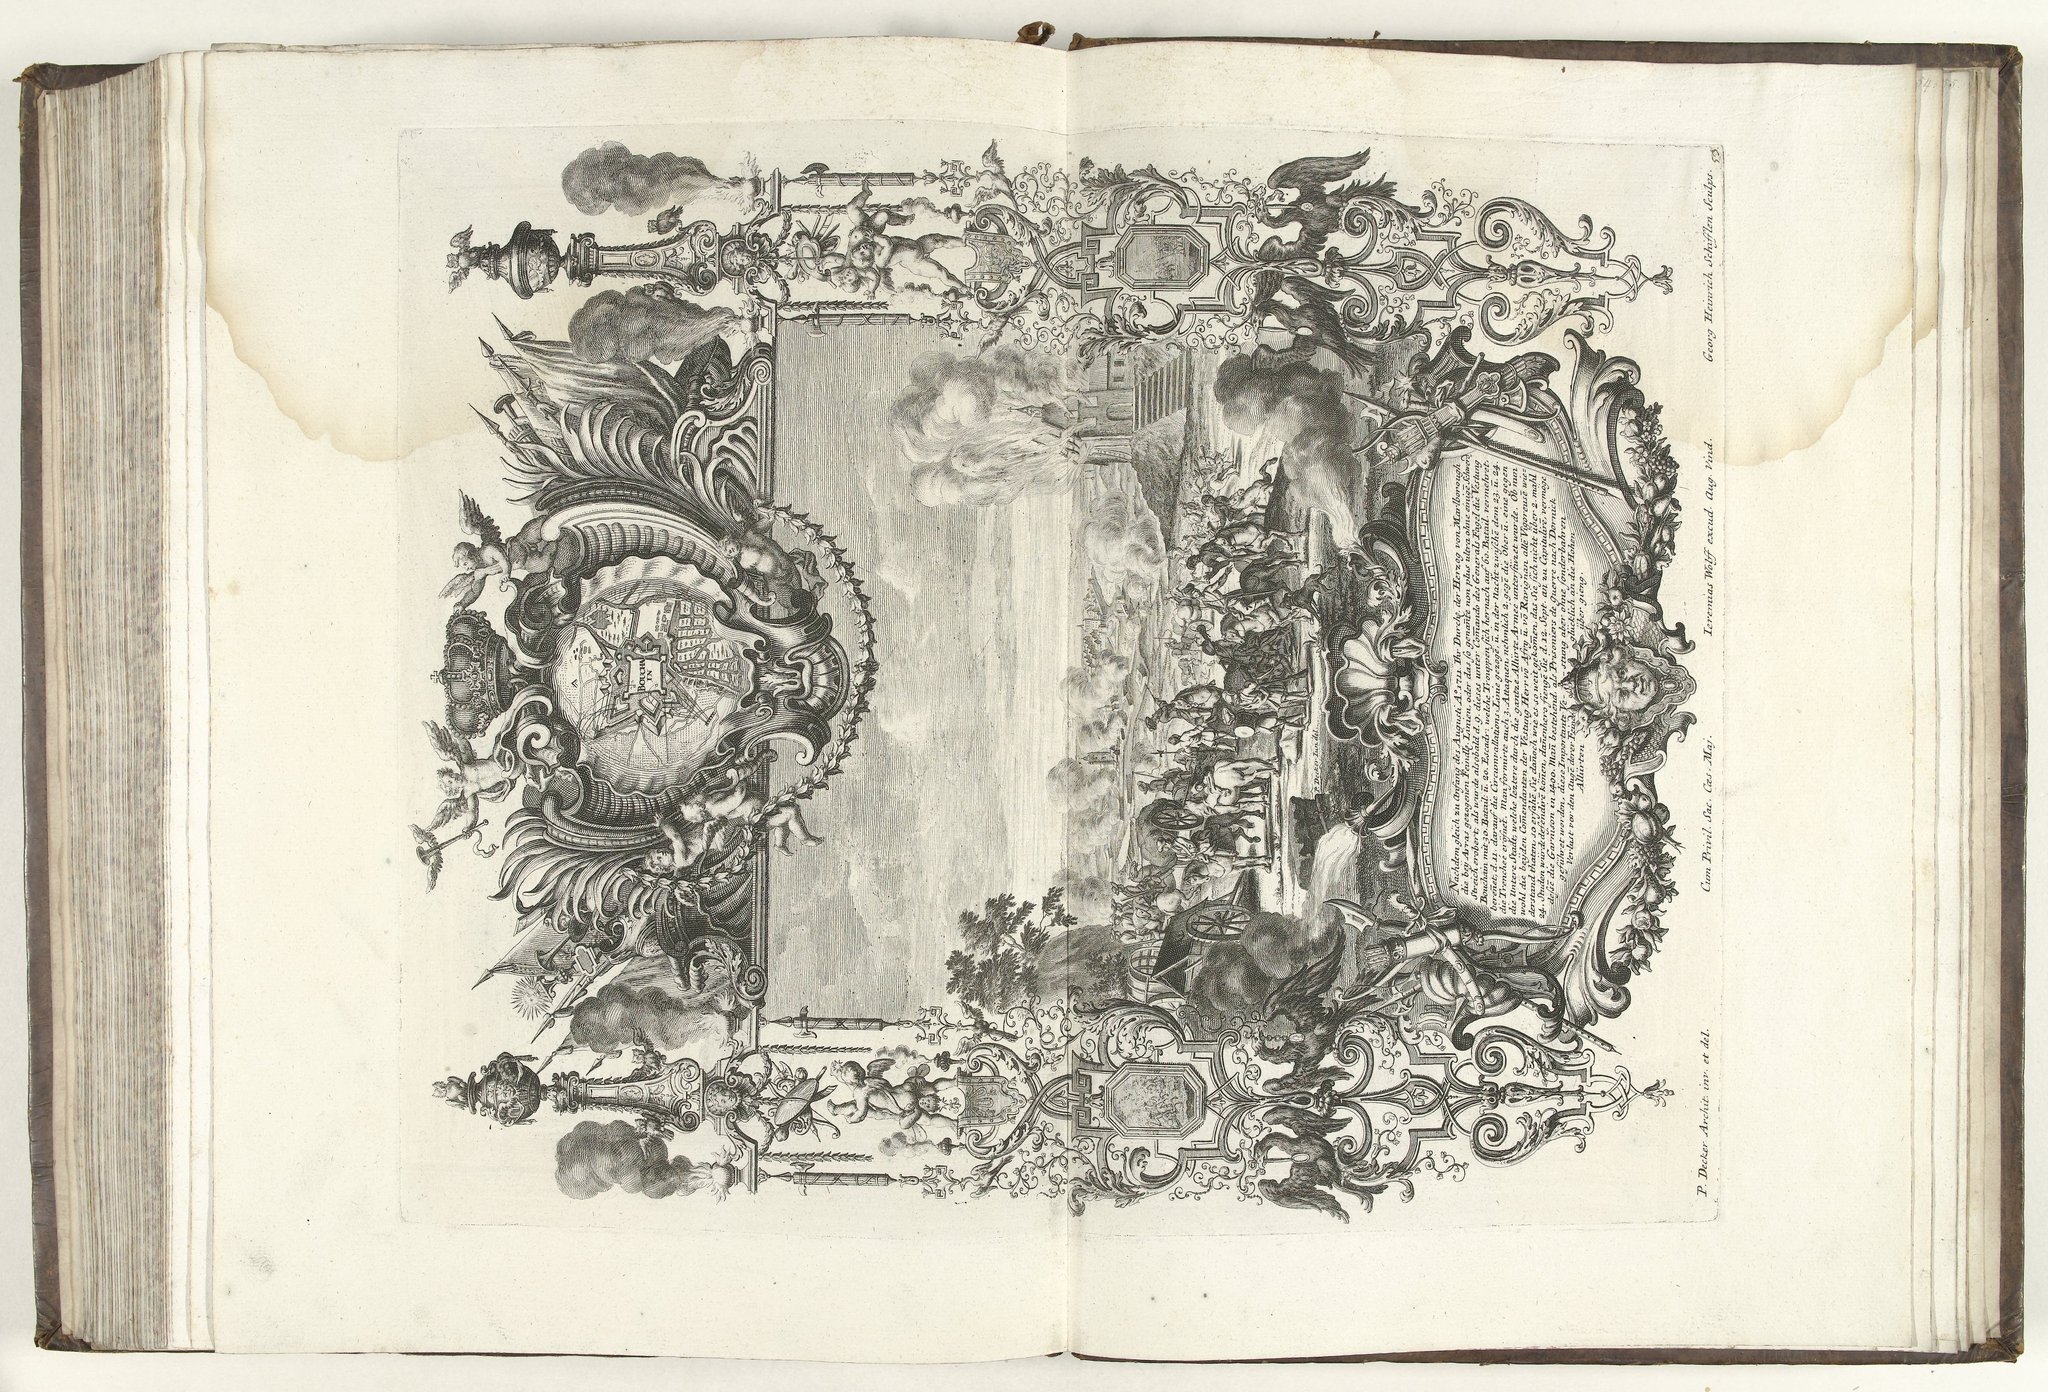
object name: history print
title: Beleg van Bouchain, 1711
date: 1712-1715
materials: paper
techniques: engraving, etching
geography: augsburg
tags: siege, position war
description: Bouchain belegerd en ingenomen door de Geallieerden op 12 september 1711. De centrale voorstelling van het beleg gevat in een rijk versierde ornamentele omlijsting met bovenaan een cartouche met een plattegrond van de stad. Onderaan een cartouche met de beschrijving van de gebeurtenissen in het Duits. Blad in de gebonden verzameling platen uitgebracht onder de titel: Repraesentatio belli ... Der Spanische Successions-Krieg [ca. 1720].